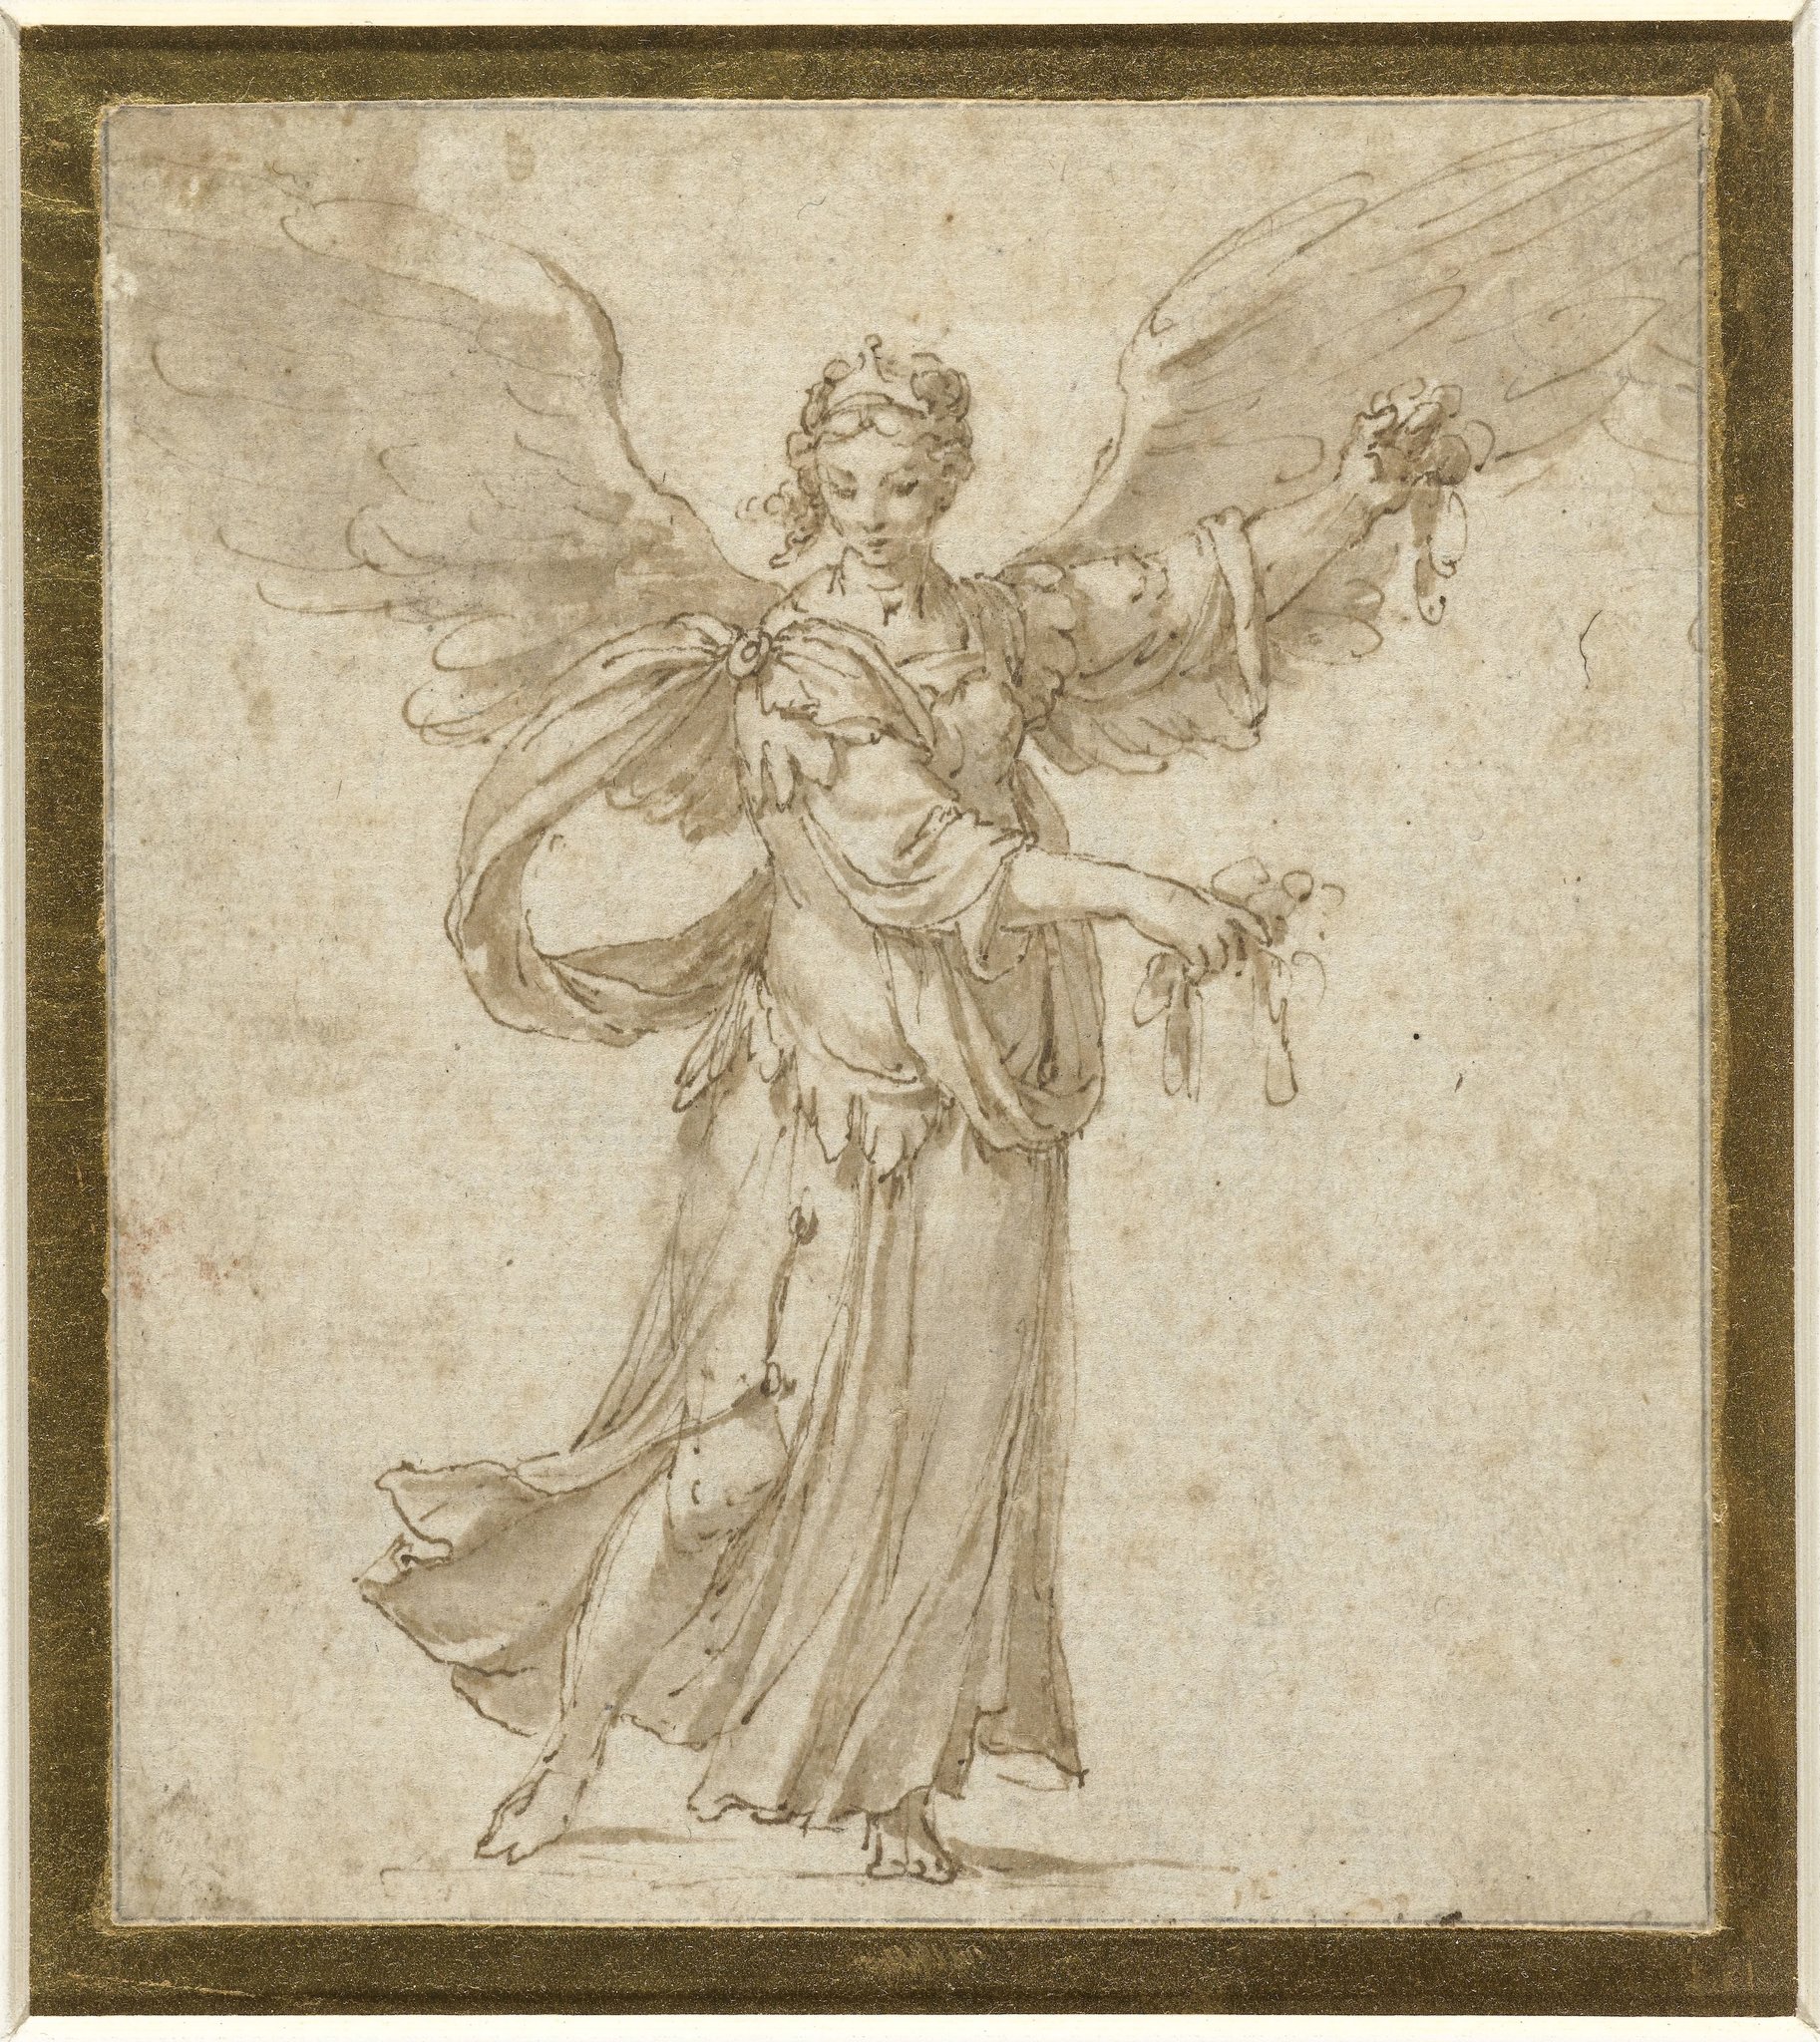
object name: drawing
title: Staande engel, met gespreide vleugels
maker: Anonymous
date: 1600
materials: ink, paper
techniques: brush, pen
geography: northern italy